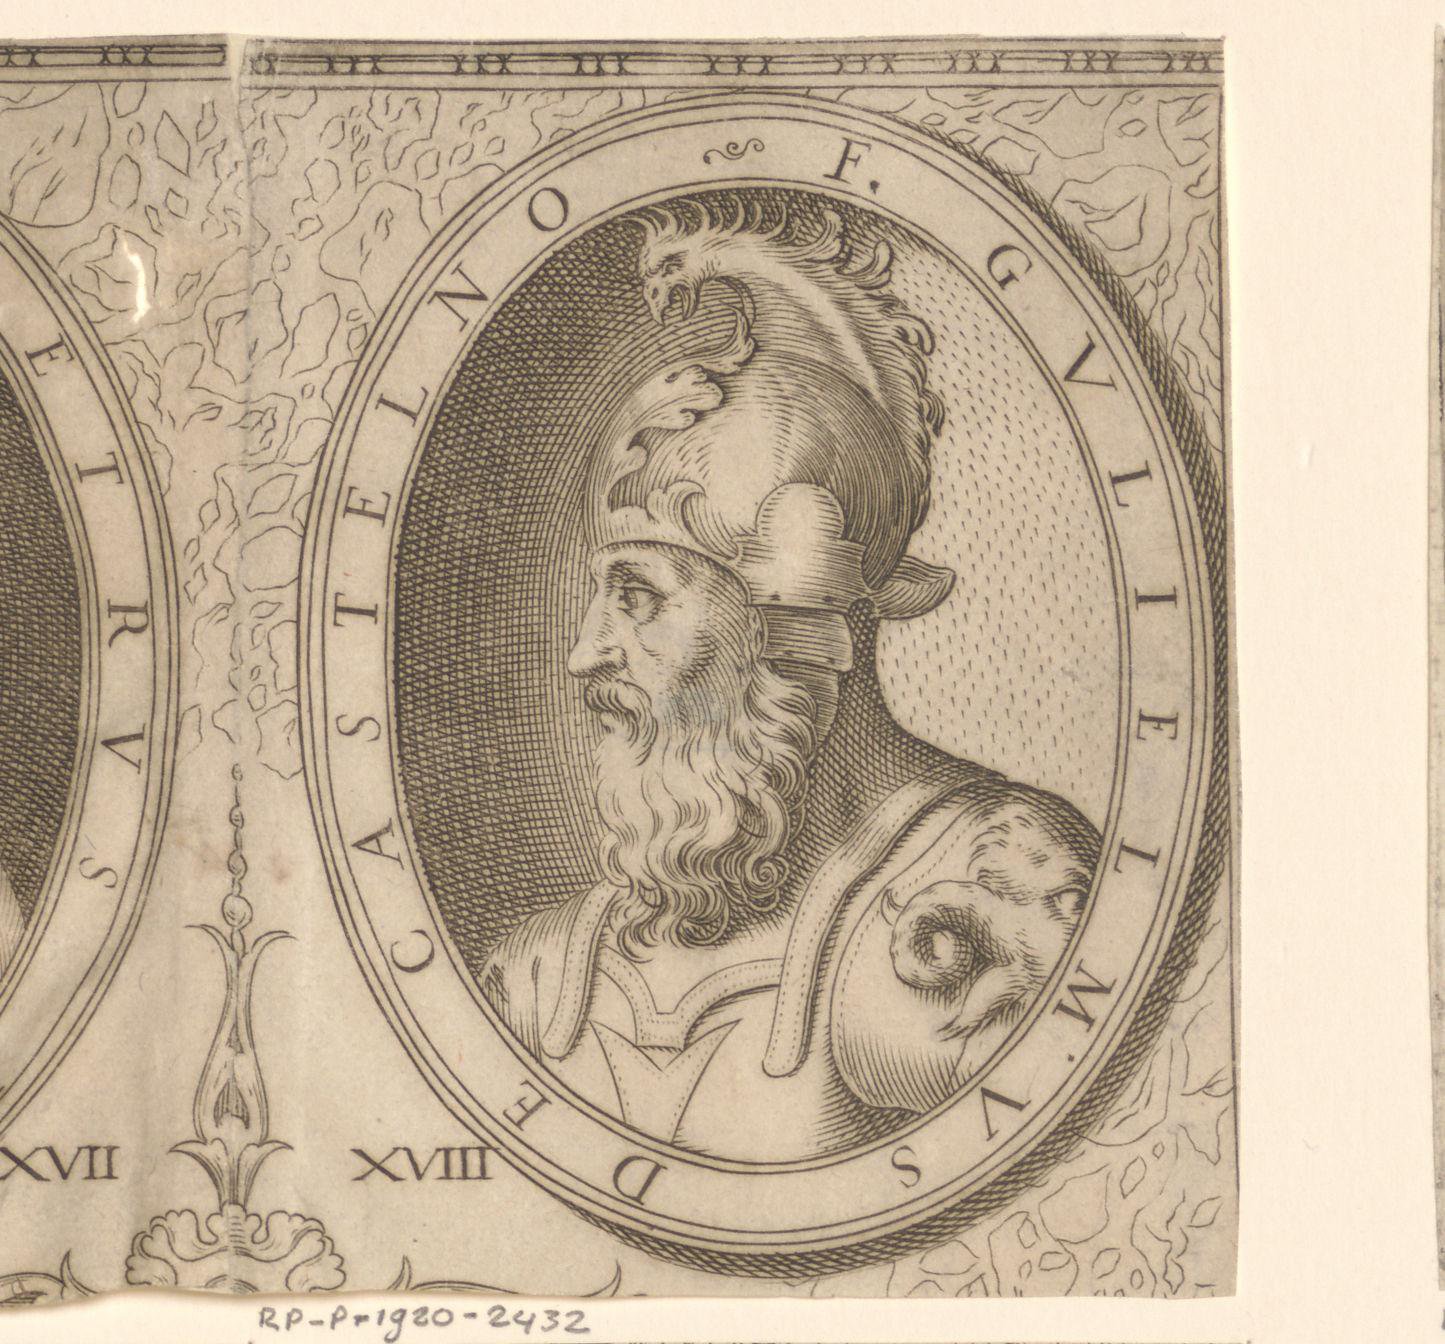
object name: print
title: Portret van Guillaume de Châteauneuf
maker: philippe thomassin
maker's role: print maker, publisher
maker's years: 1562-1622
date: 1588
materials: paper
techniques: engraving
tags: historical persons, military orders, e.g.: knights templars, knights of malta, teutonic knights ~ roman catholic church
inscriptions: collector's mark: Lugt 2228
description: Deze prent maakt deel uit van een grotere prent met vier portretten die later is verknipt. Prent waarschijnlijk uit: Veltroni, Tolomeo. Statuta hospitalis Hierusalem. [Rome: s.n., 1588].